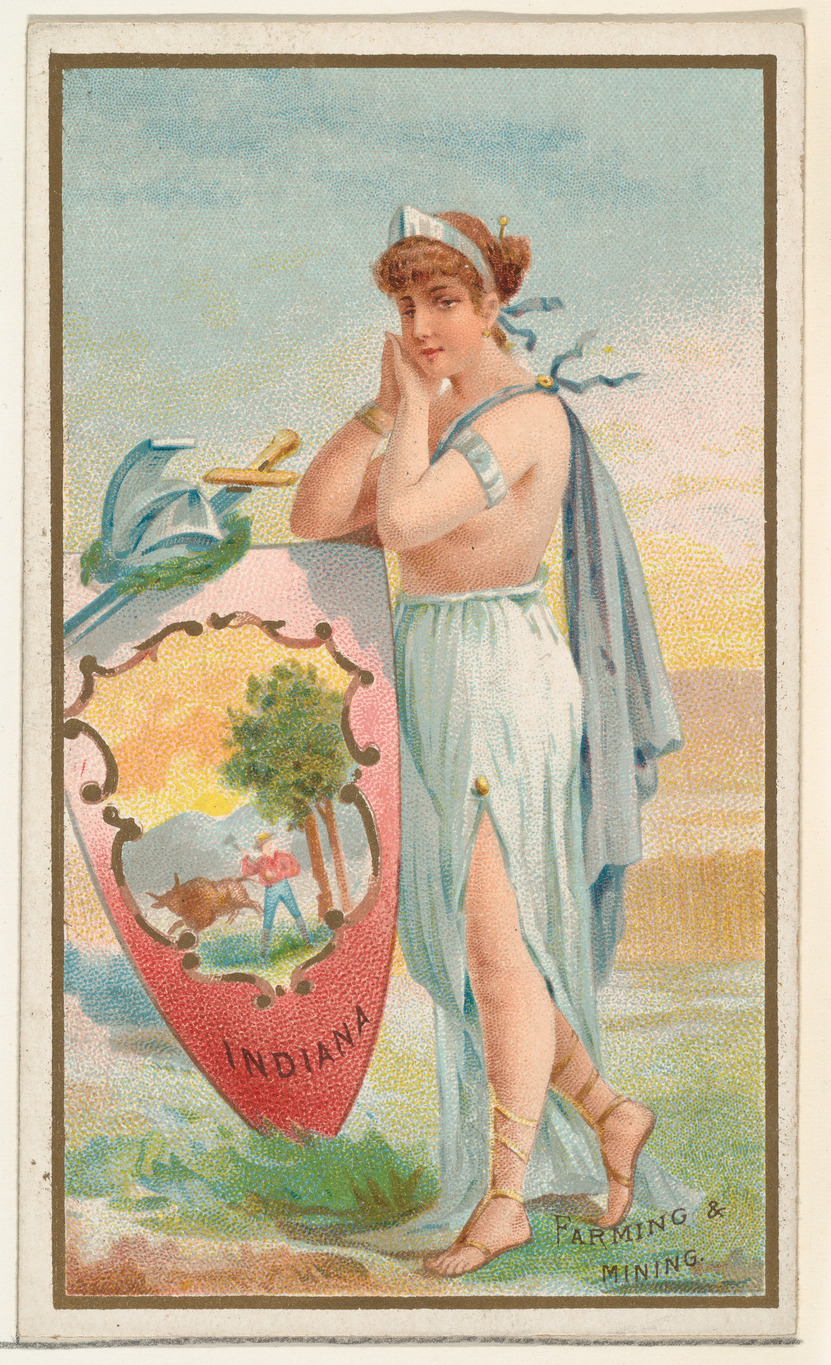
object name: print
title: Indiana, from the Industries of States series (N117) issued by Duke Sons & Co. to promote Honest Long Cut Tobacco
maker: w. duke, sons & co.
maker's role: publisher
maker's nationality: american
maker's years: 1870-1920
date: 1889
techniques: color lithograph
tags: shields,women